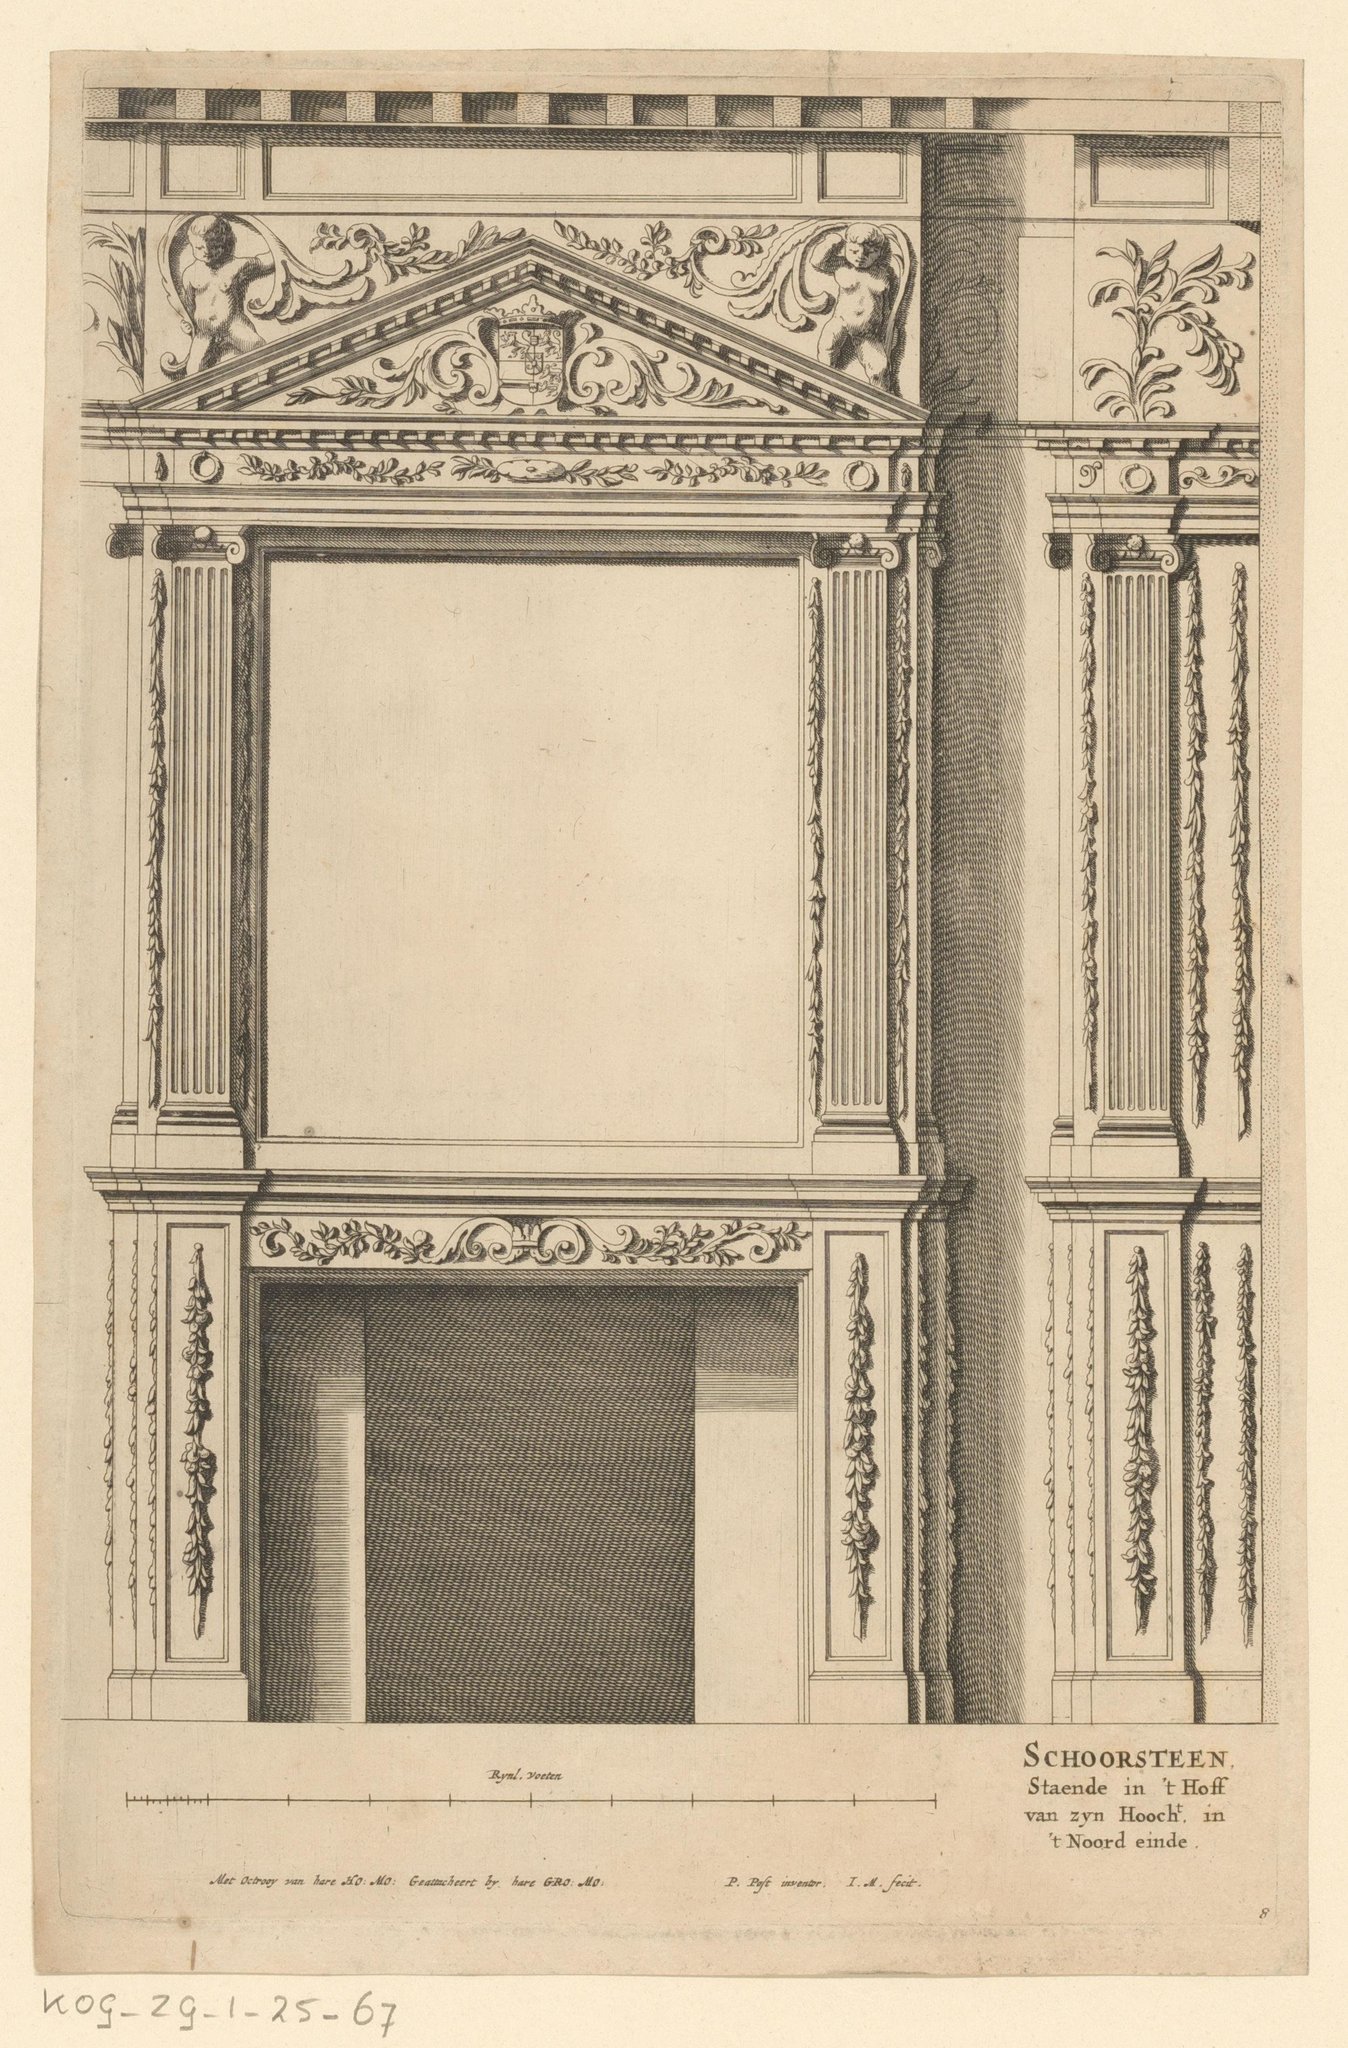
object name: print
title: Voor- en zijgezicht van een schouw met timpaan uit het Paleis Noordeinde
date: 1669-1706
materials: paper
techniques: engraving, etching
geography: amsterdam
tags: chimney, chimney ornaments, chimney-piece, mantelpiece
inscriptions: stamp:, stamp:, : ‘Met Octrooy van hare HO: MO: Geattacheert bij hare GRO: MO:’, collector's mark: Lugt 1641a, collector's mark: Lugt 1641, stamp:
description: Titelprent is onderdeel van een serie bestaande uit een titelprent en 22 vervolg prenten. De serie is voor het eerst uitgegeven door Pieter Jansz. Post in Den Haag of Rotterdam. De huidige (tweede staat) is uitgegeven door Frederik de Wit tussen 1669 en 1706. De volgorde van de prenten is in deze serie veranderd. De prenten zijn een derde keer uitgegeven door Pieter van der Aa in 1715 te Leiden. Hier is de volgorde wederom aangepast.